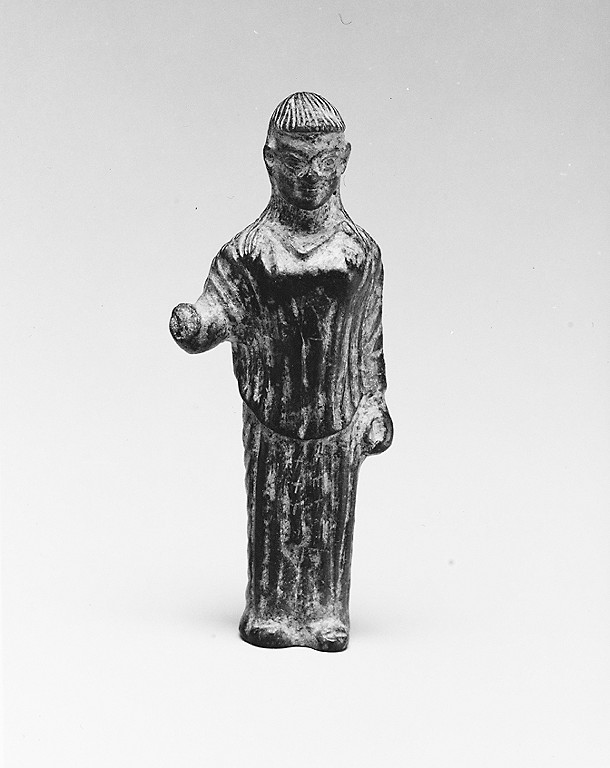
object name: statuette of a woman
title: Bronze statuette of a woman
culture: greek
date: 567-535 BCE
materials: bronze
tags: women